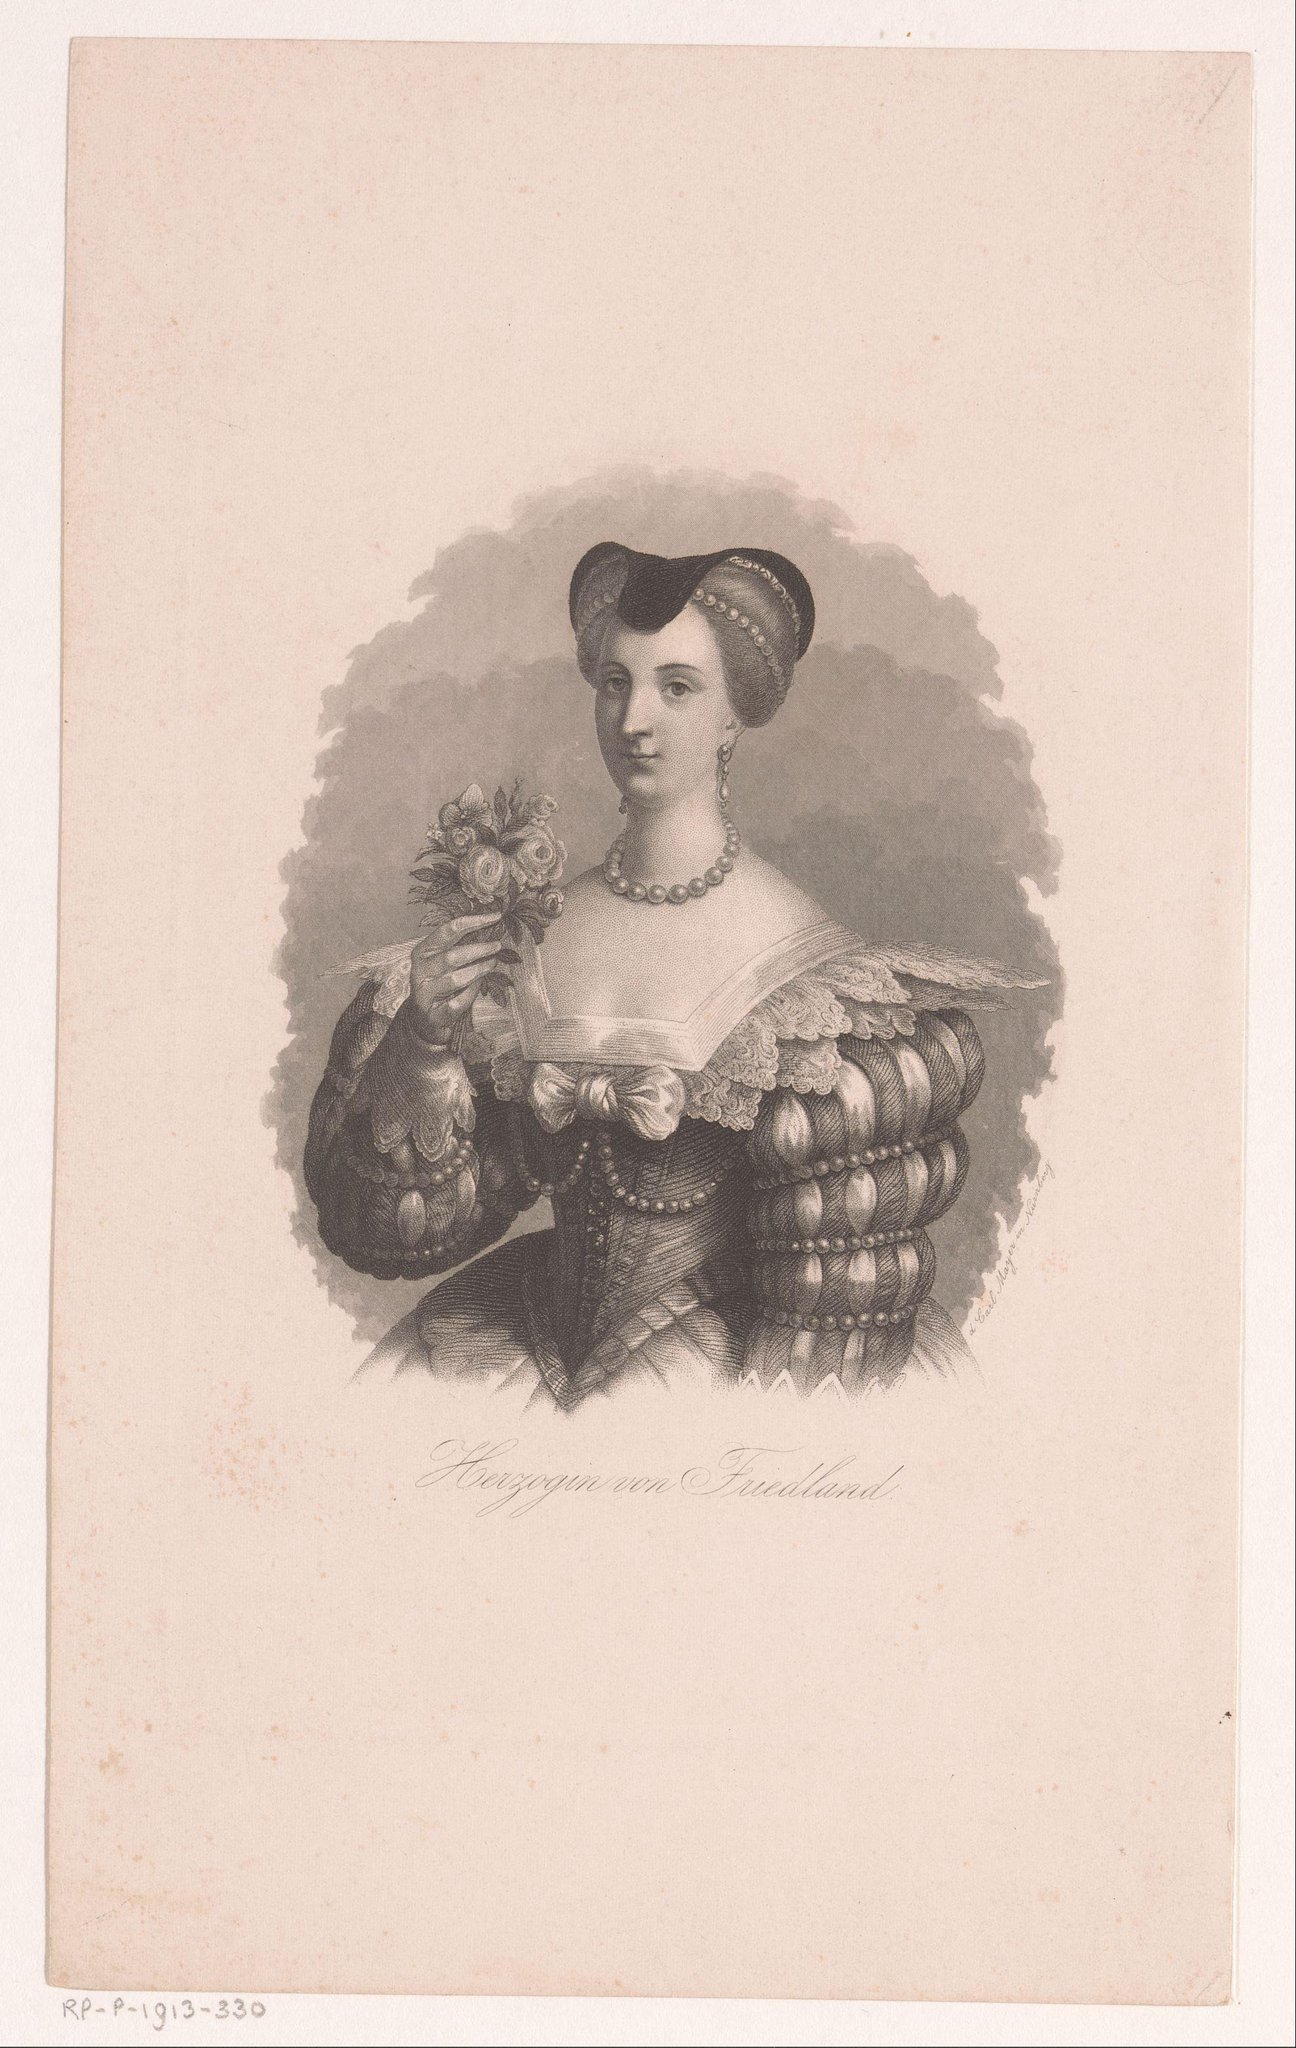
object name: print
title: Portret van de hertogin van Friedland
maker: carl mayer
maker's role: print maker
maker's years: 1798-1868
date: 1808-1868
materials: paper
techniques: engraving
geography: nuremberg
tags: historical persons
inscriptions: collector's mark: Lugt 2228